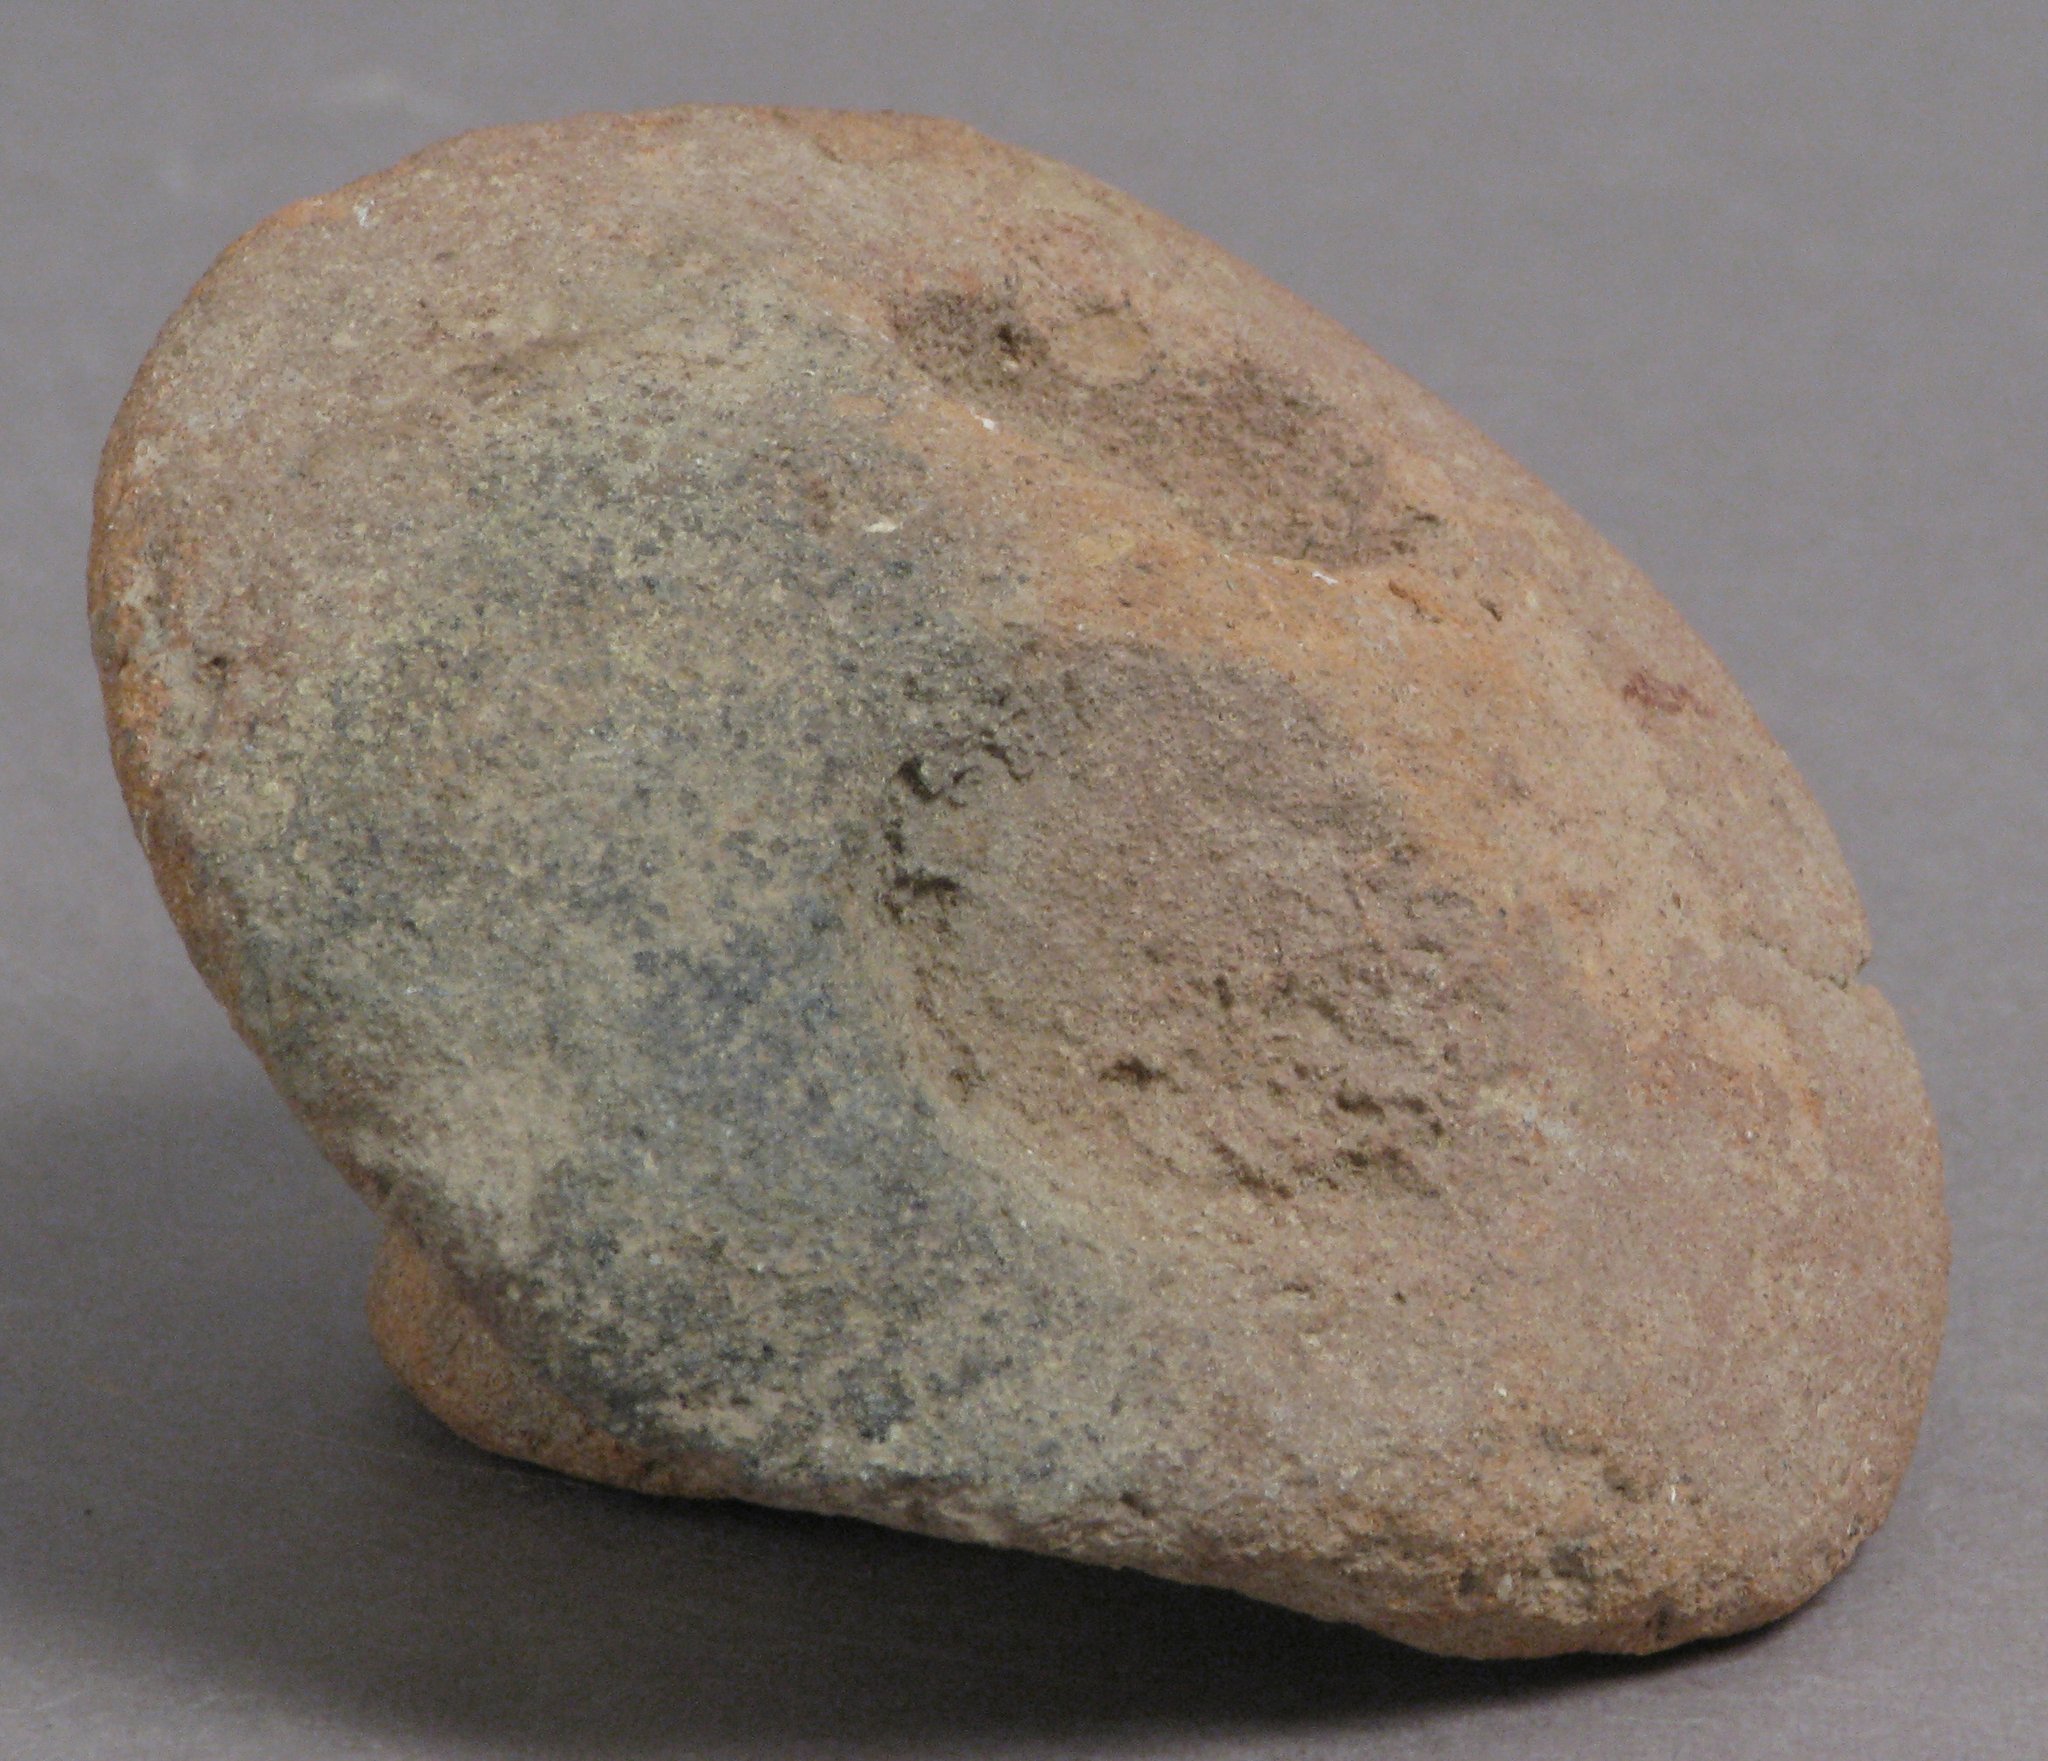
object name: lid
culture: coptic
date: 301-700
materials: earthenware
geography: egypt